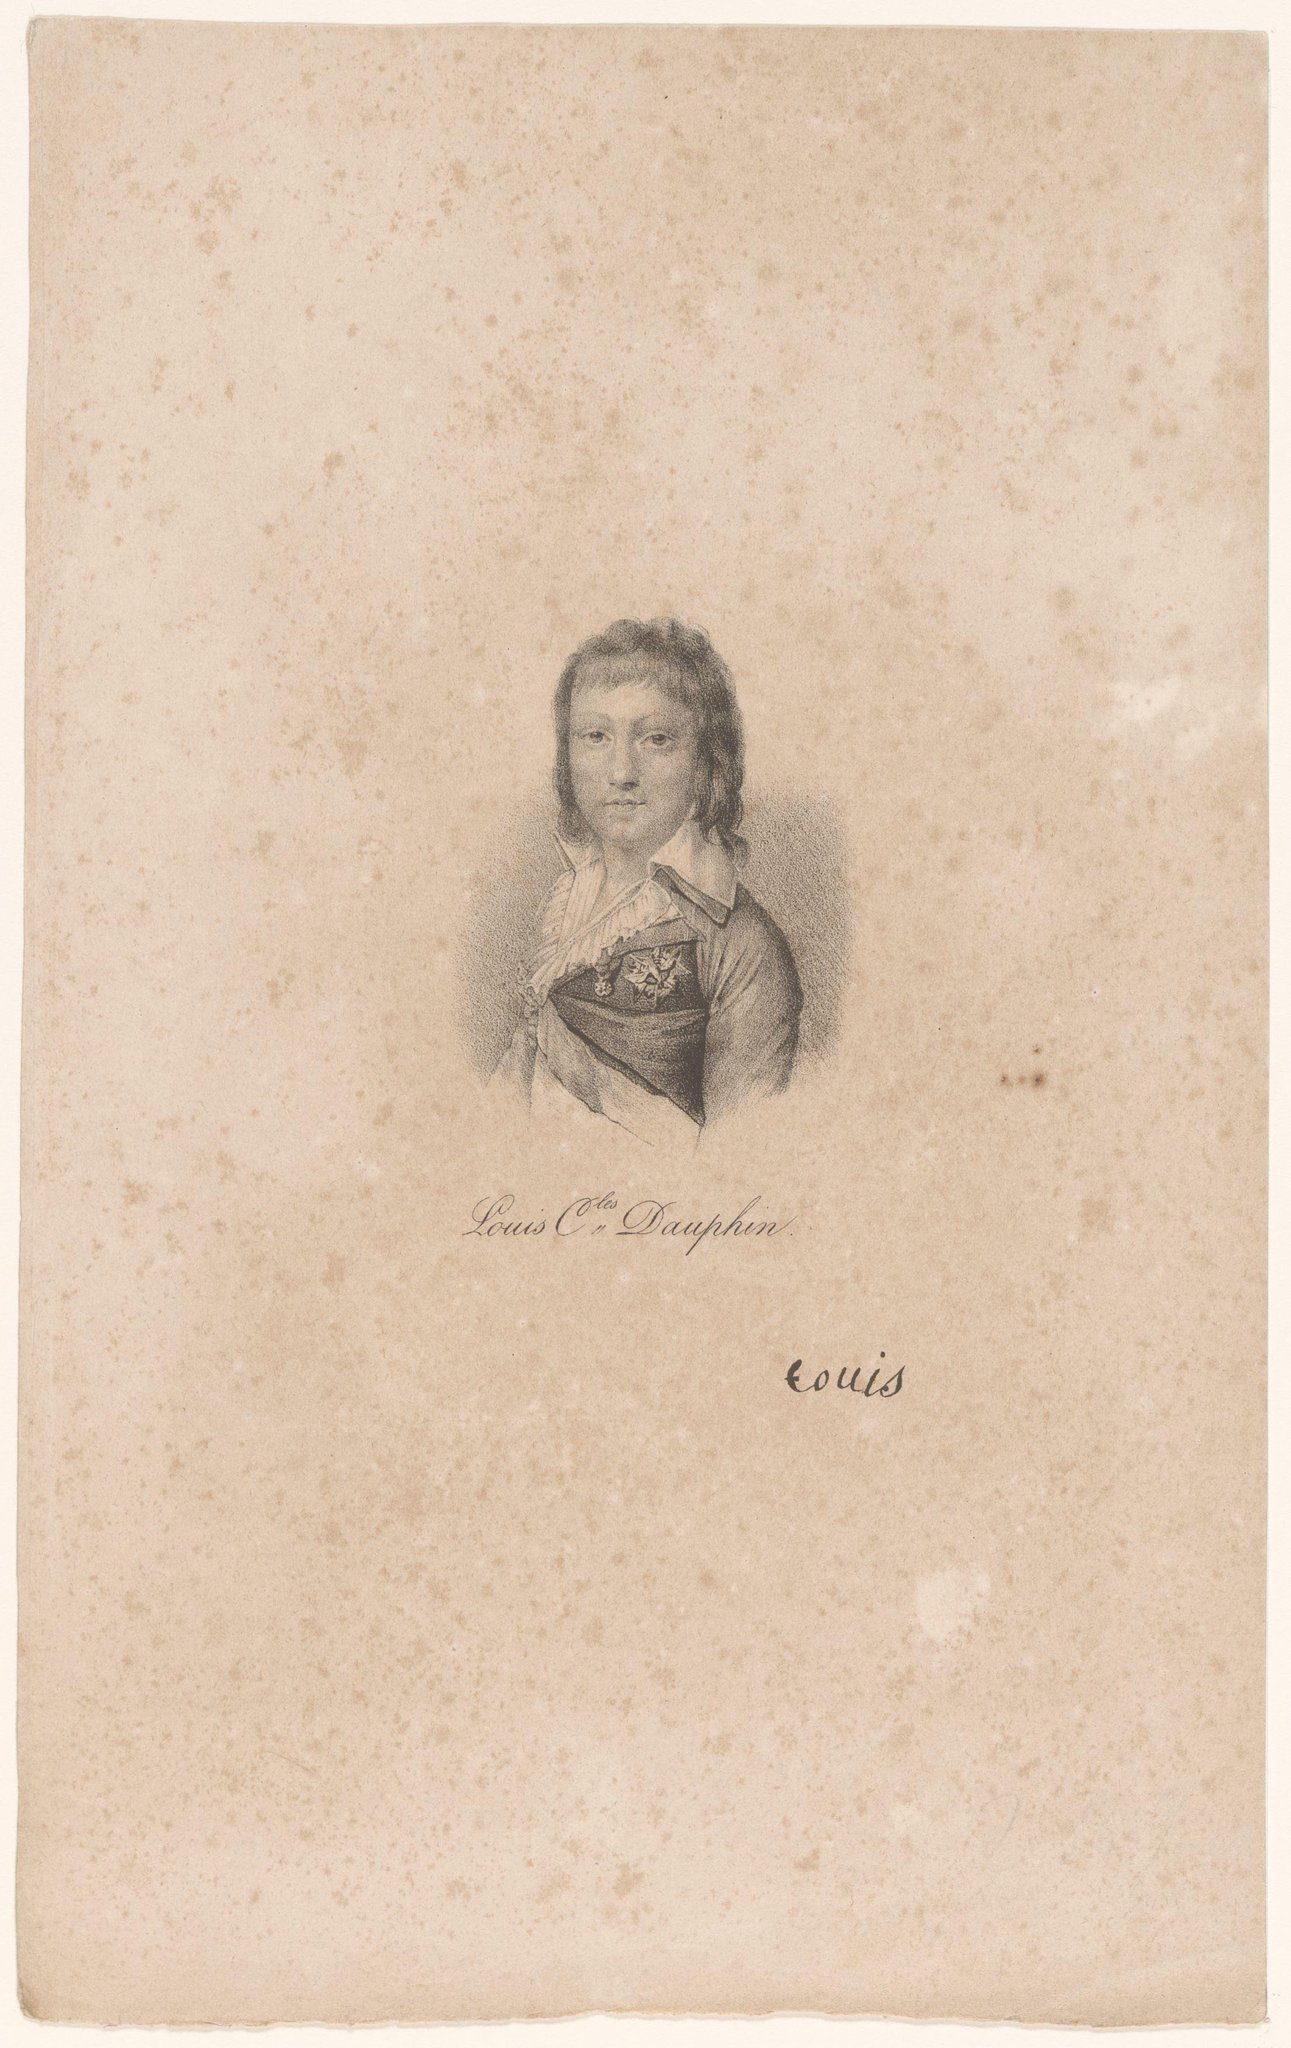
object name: print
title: Portret van Lodewijk XVII van Frankrijk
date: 1818-1842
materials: paper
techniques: lithograph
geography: paris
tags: historical persons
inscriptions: collector's mark: Lugt 2228a